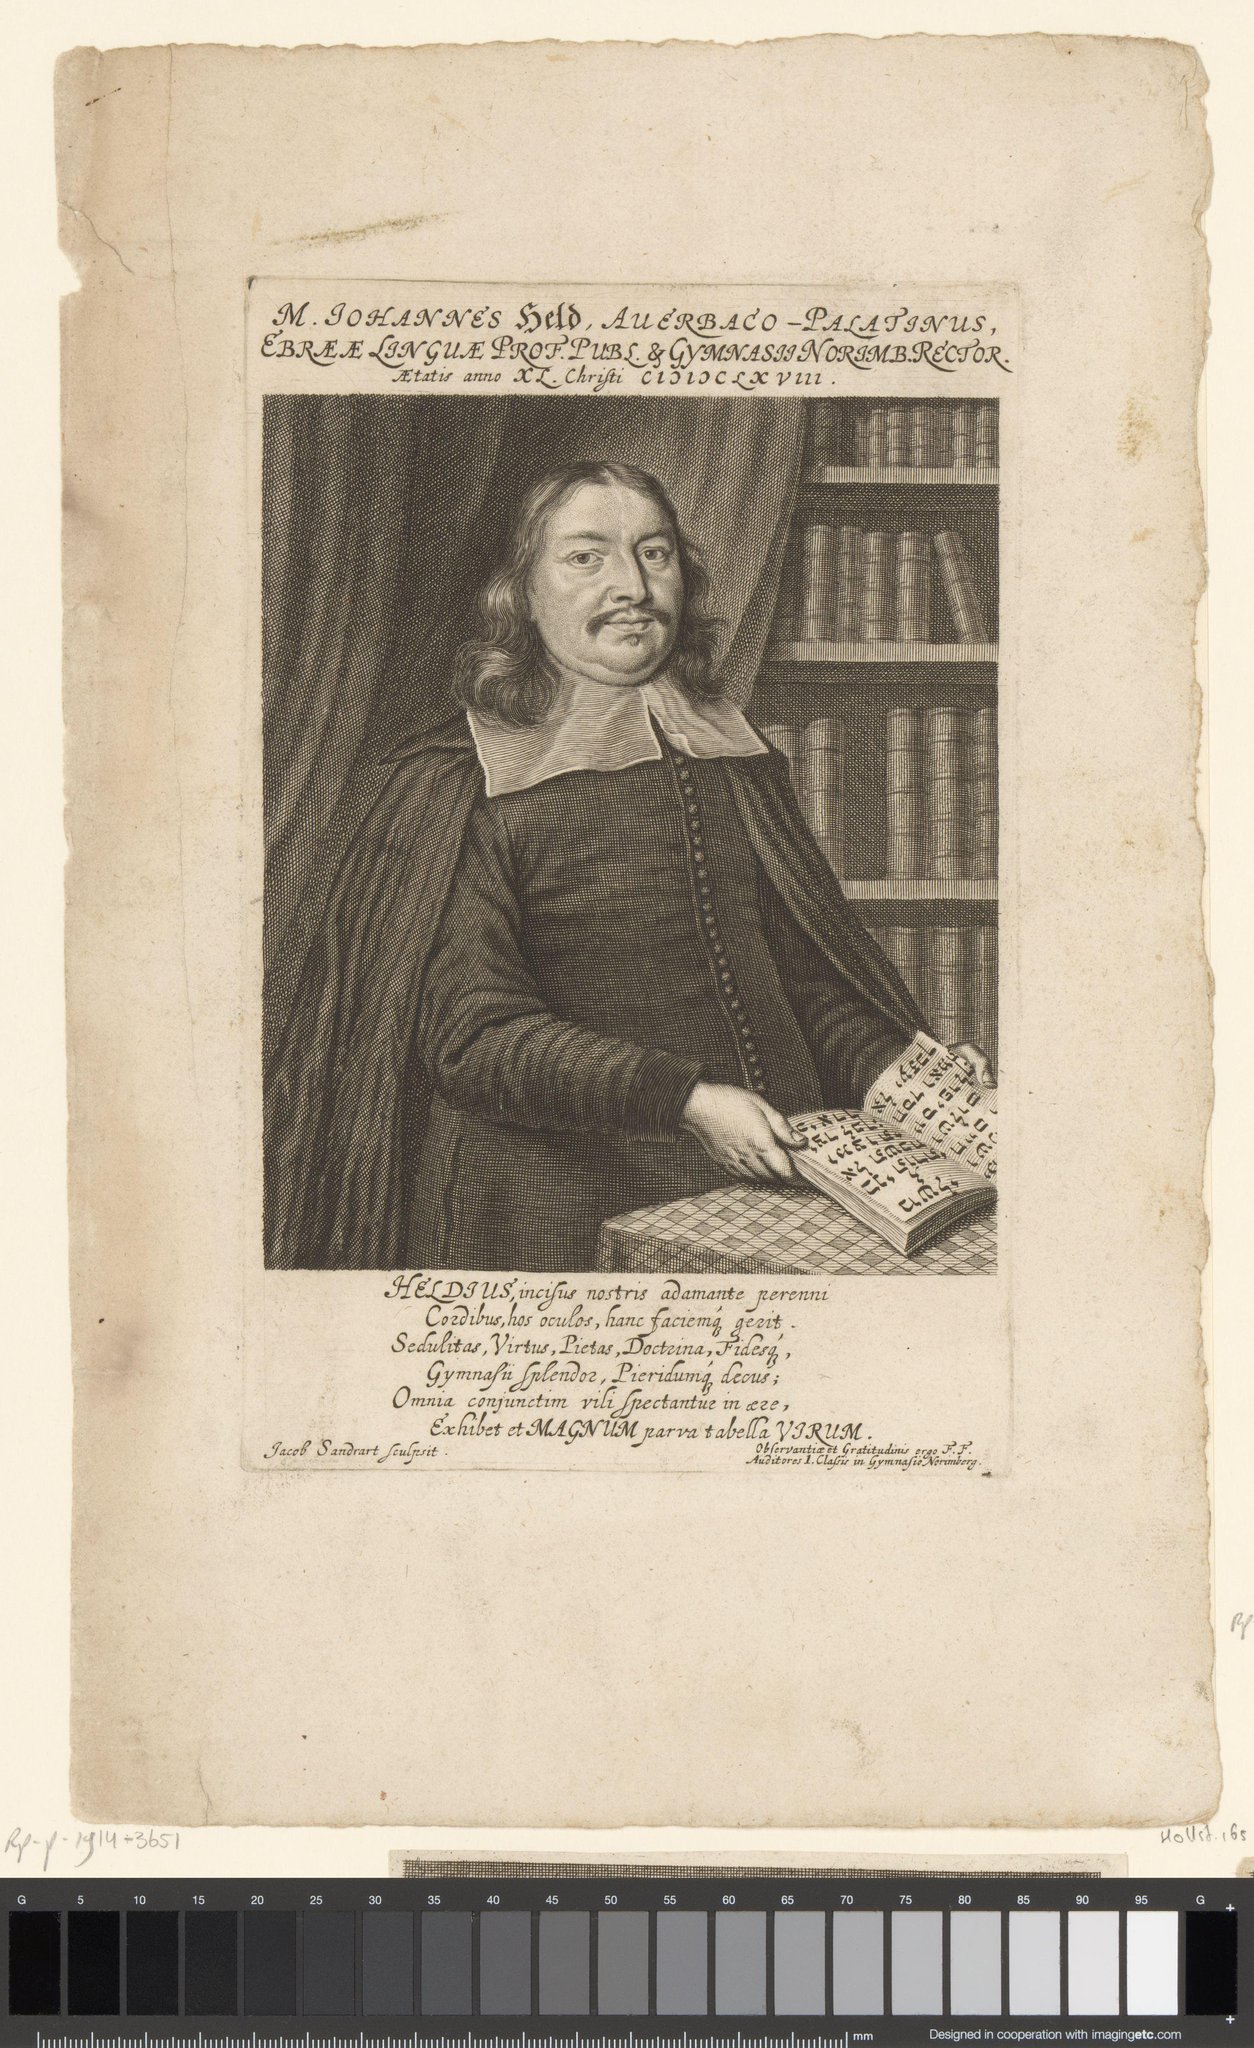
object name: print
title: Portret van Johann Held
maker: jakob von sandrart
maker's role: print maker, publisher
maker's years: 1630-1708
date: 1668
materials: paper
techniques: engraving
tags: bookshelves, historical persons, book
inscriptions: collector's mark: Lugt 2228